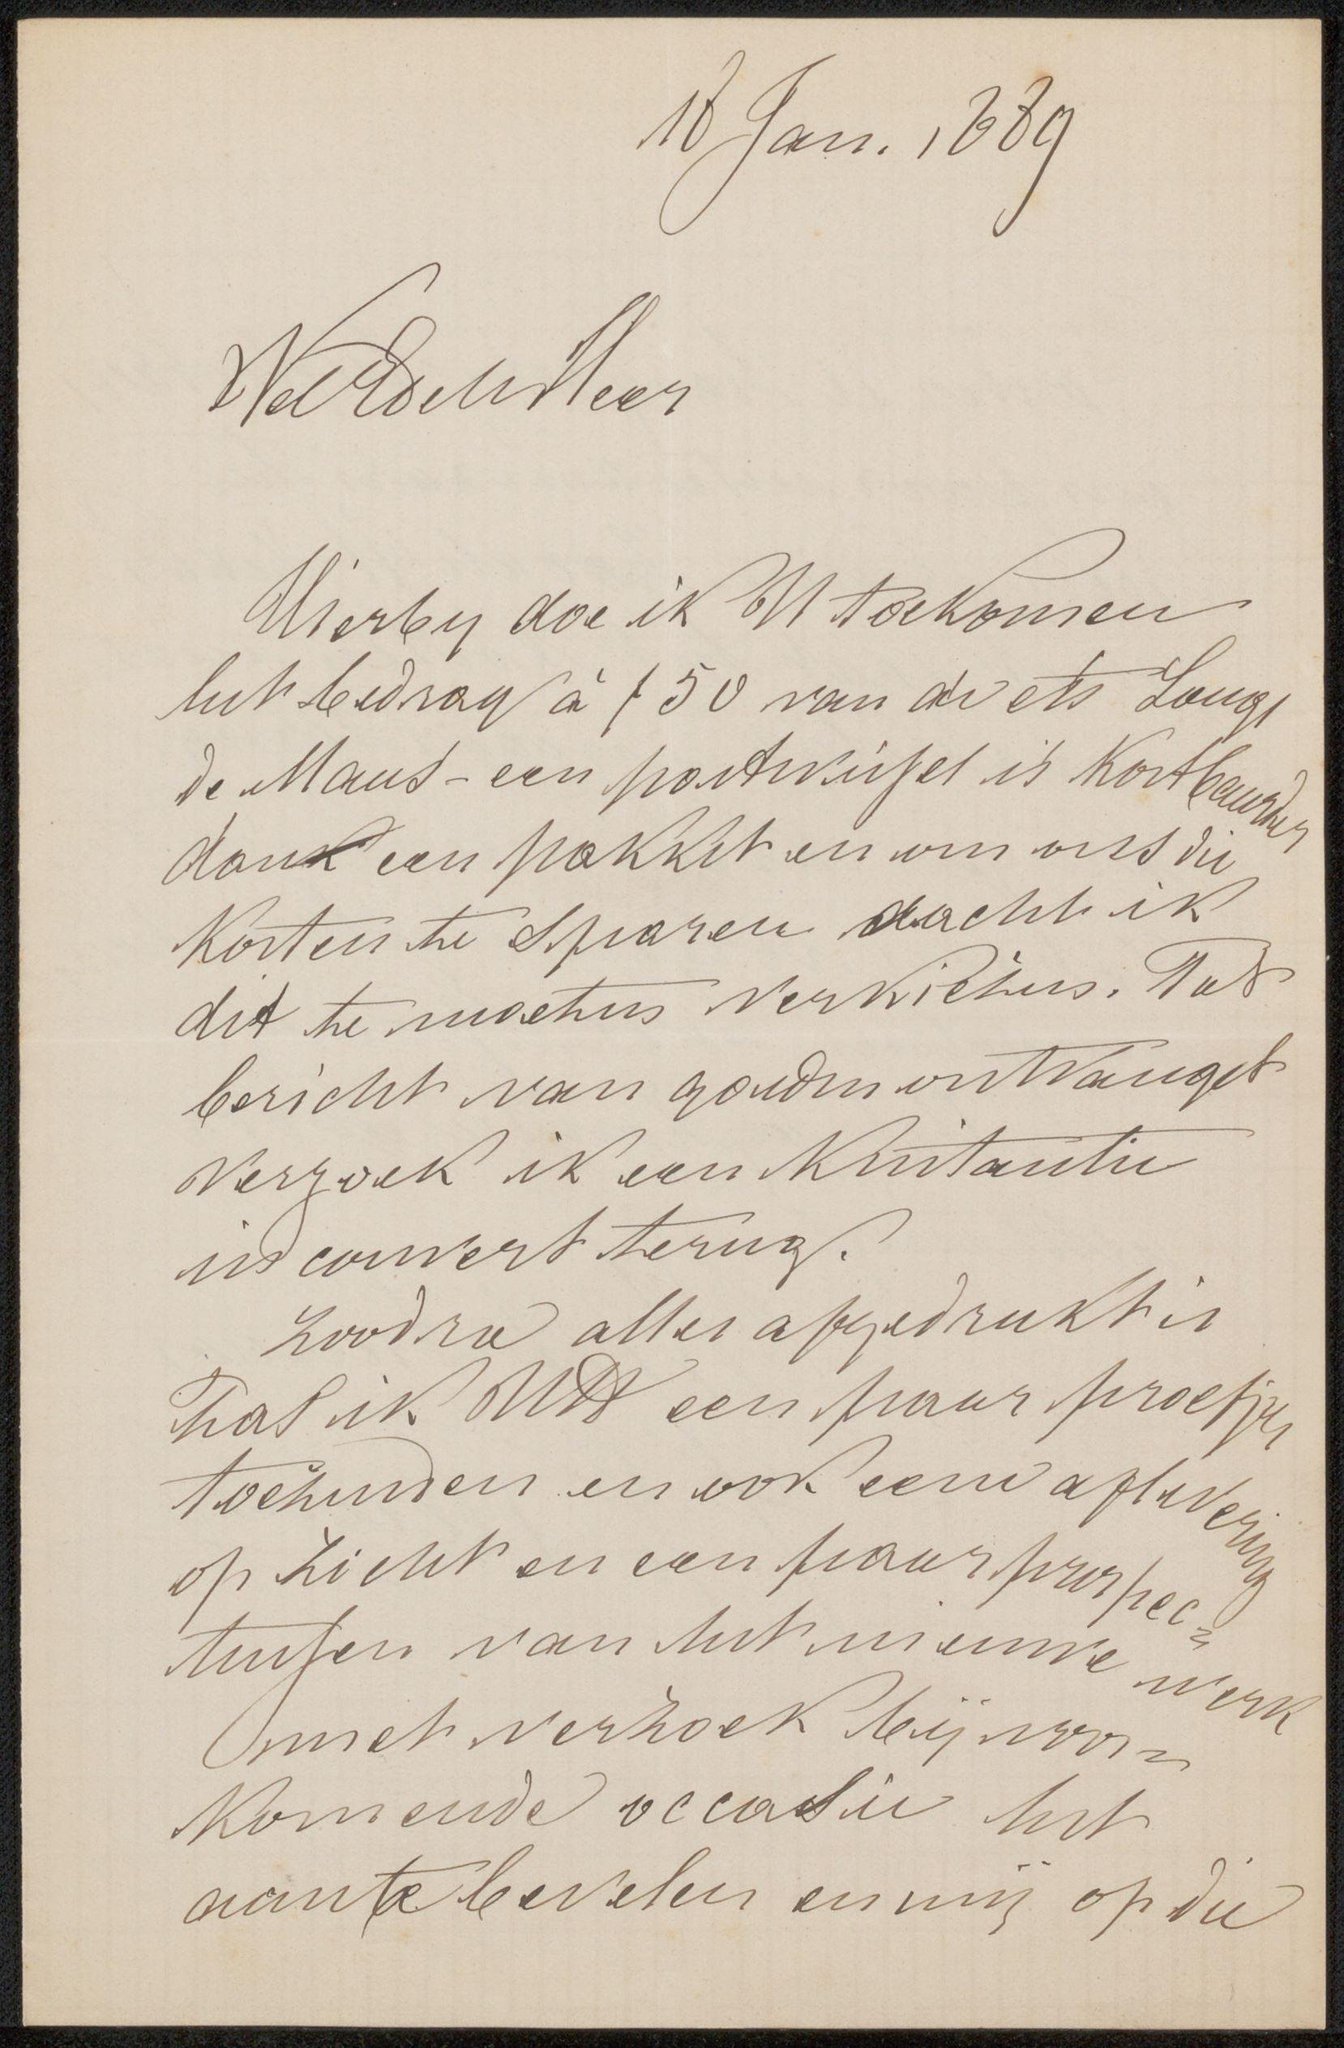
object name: letter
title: Brief aan Philip Zilcken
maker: edouard taurel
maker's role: draughtsman, print maker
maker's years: 1824-1892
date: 1889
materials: ink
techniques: pen, writing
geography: amsterdam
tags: the hague, painter, draughtsman, philip zilcken, the graphic arts, money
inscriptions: collector's mark: ‘RPK’